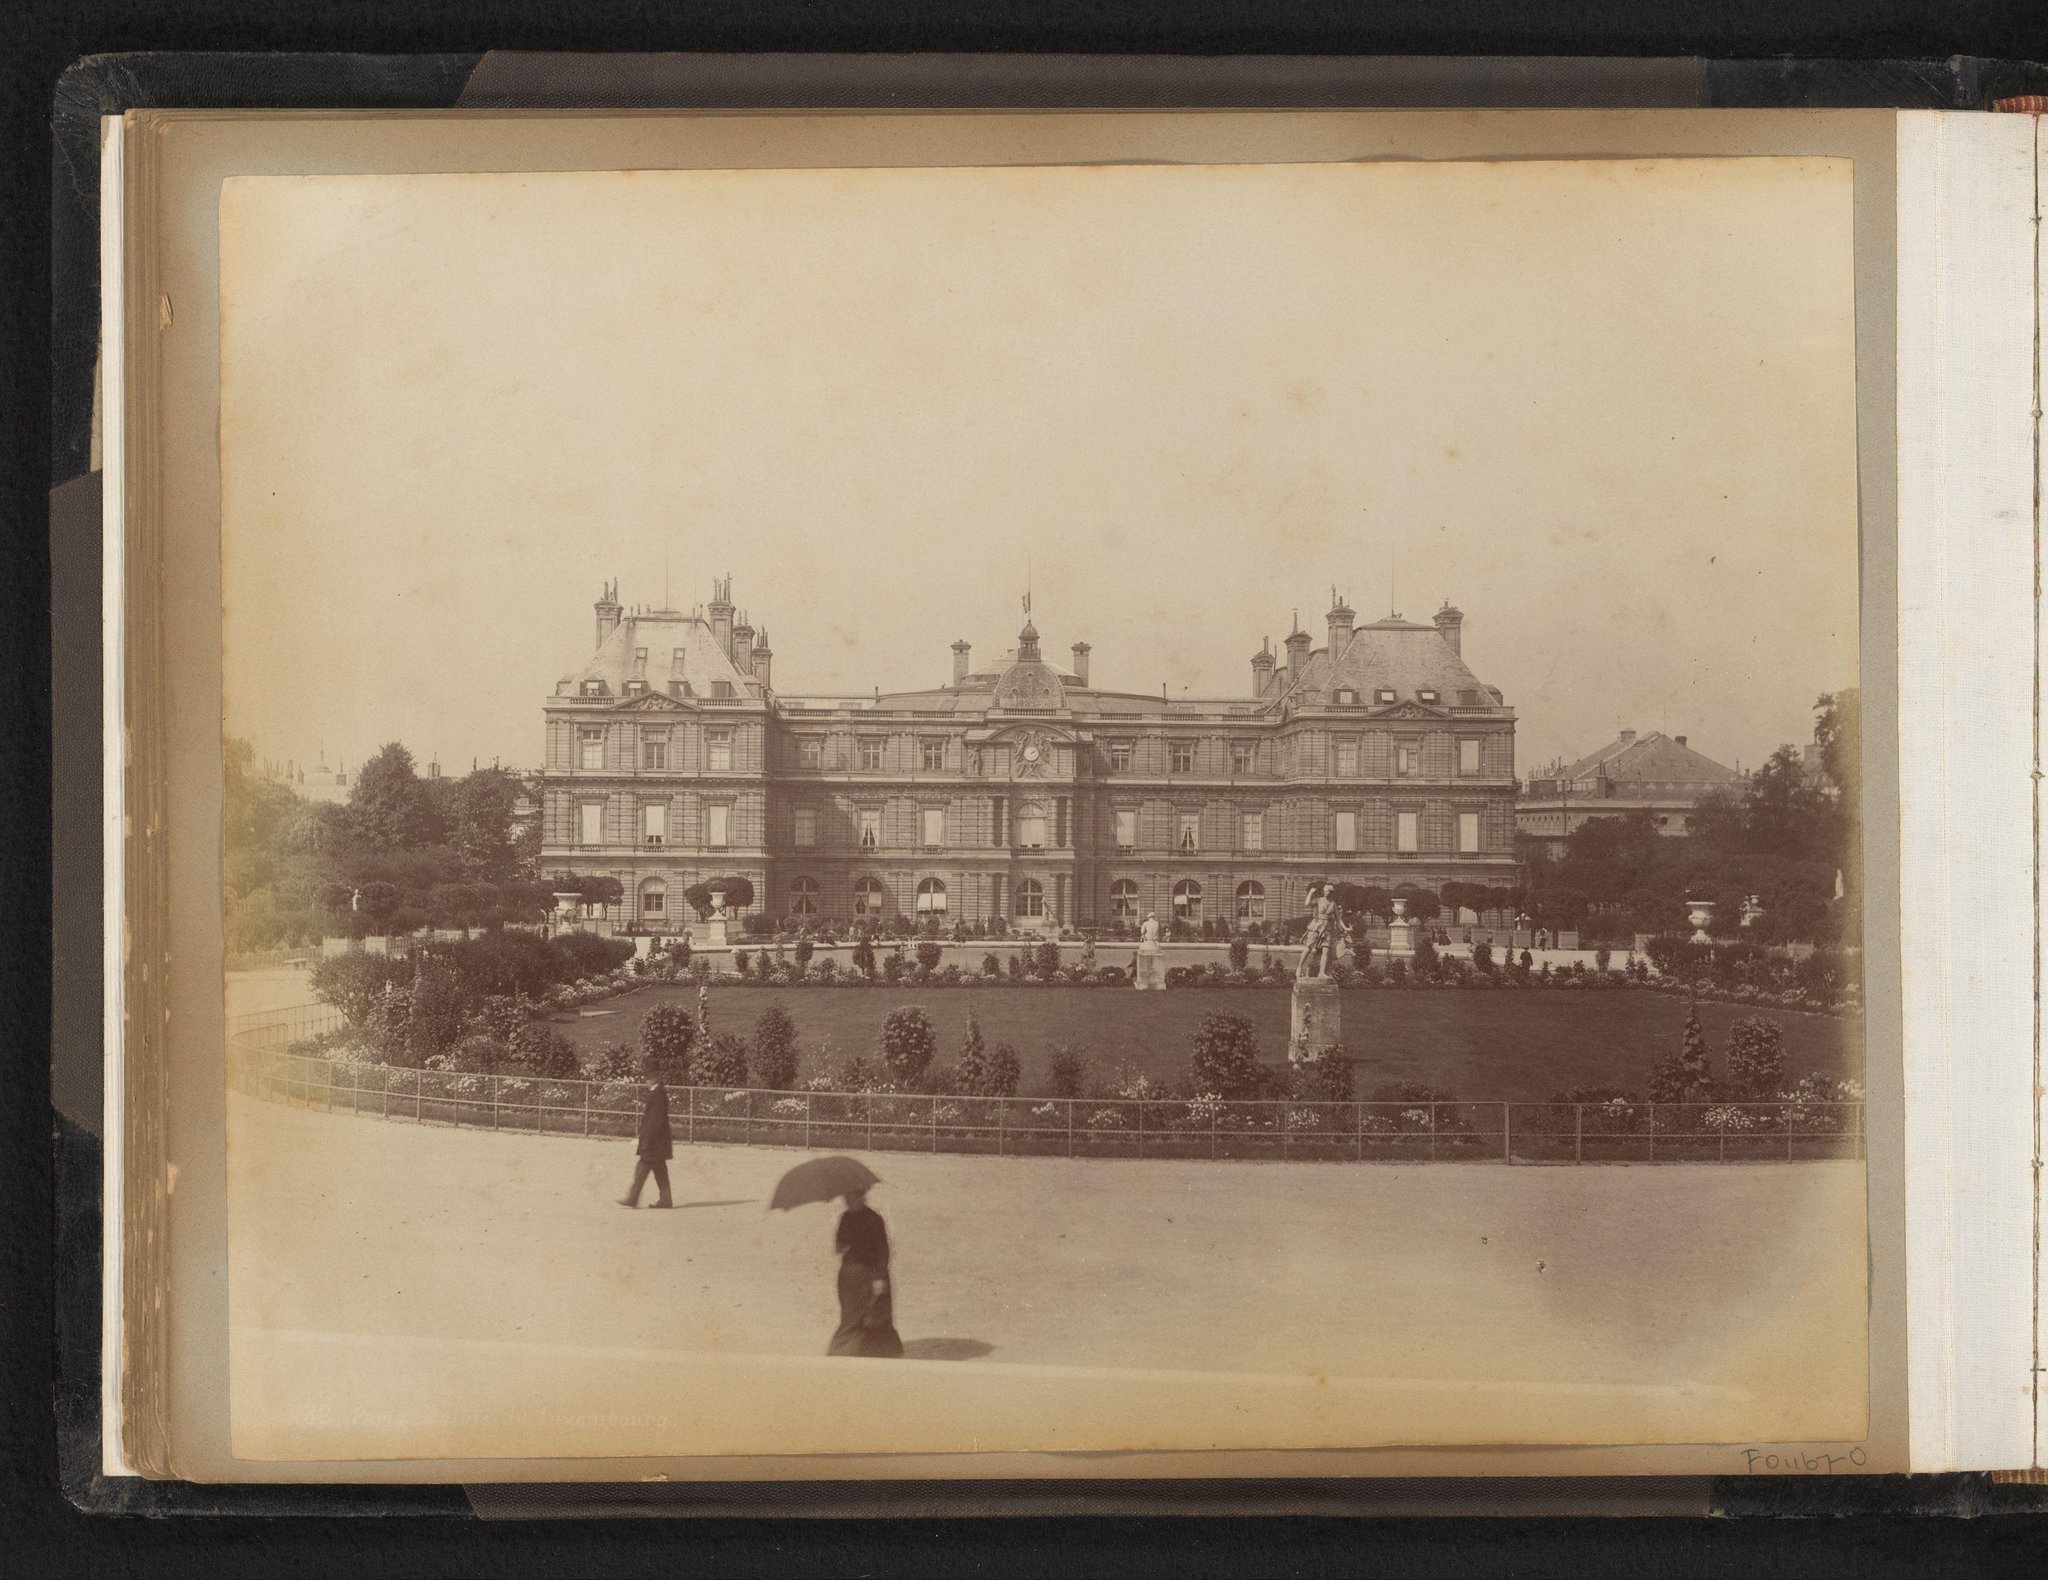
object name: album leaf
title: Musée du Louvre gezien vanuit de Jardin des Tuileries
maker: Anonymous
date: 1880-1910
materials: photographic support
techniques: albumen print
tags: façade (of house or building)